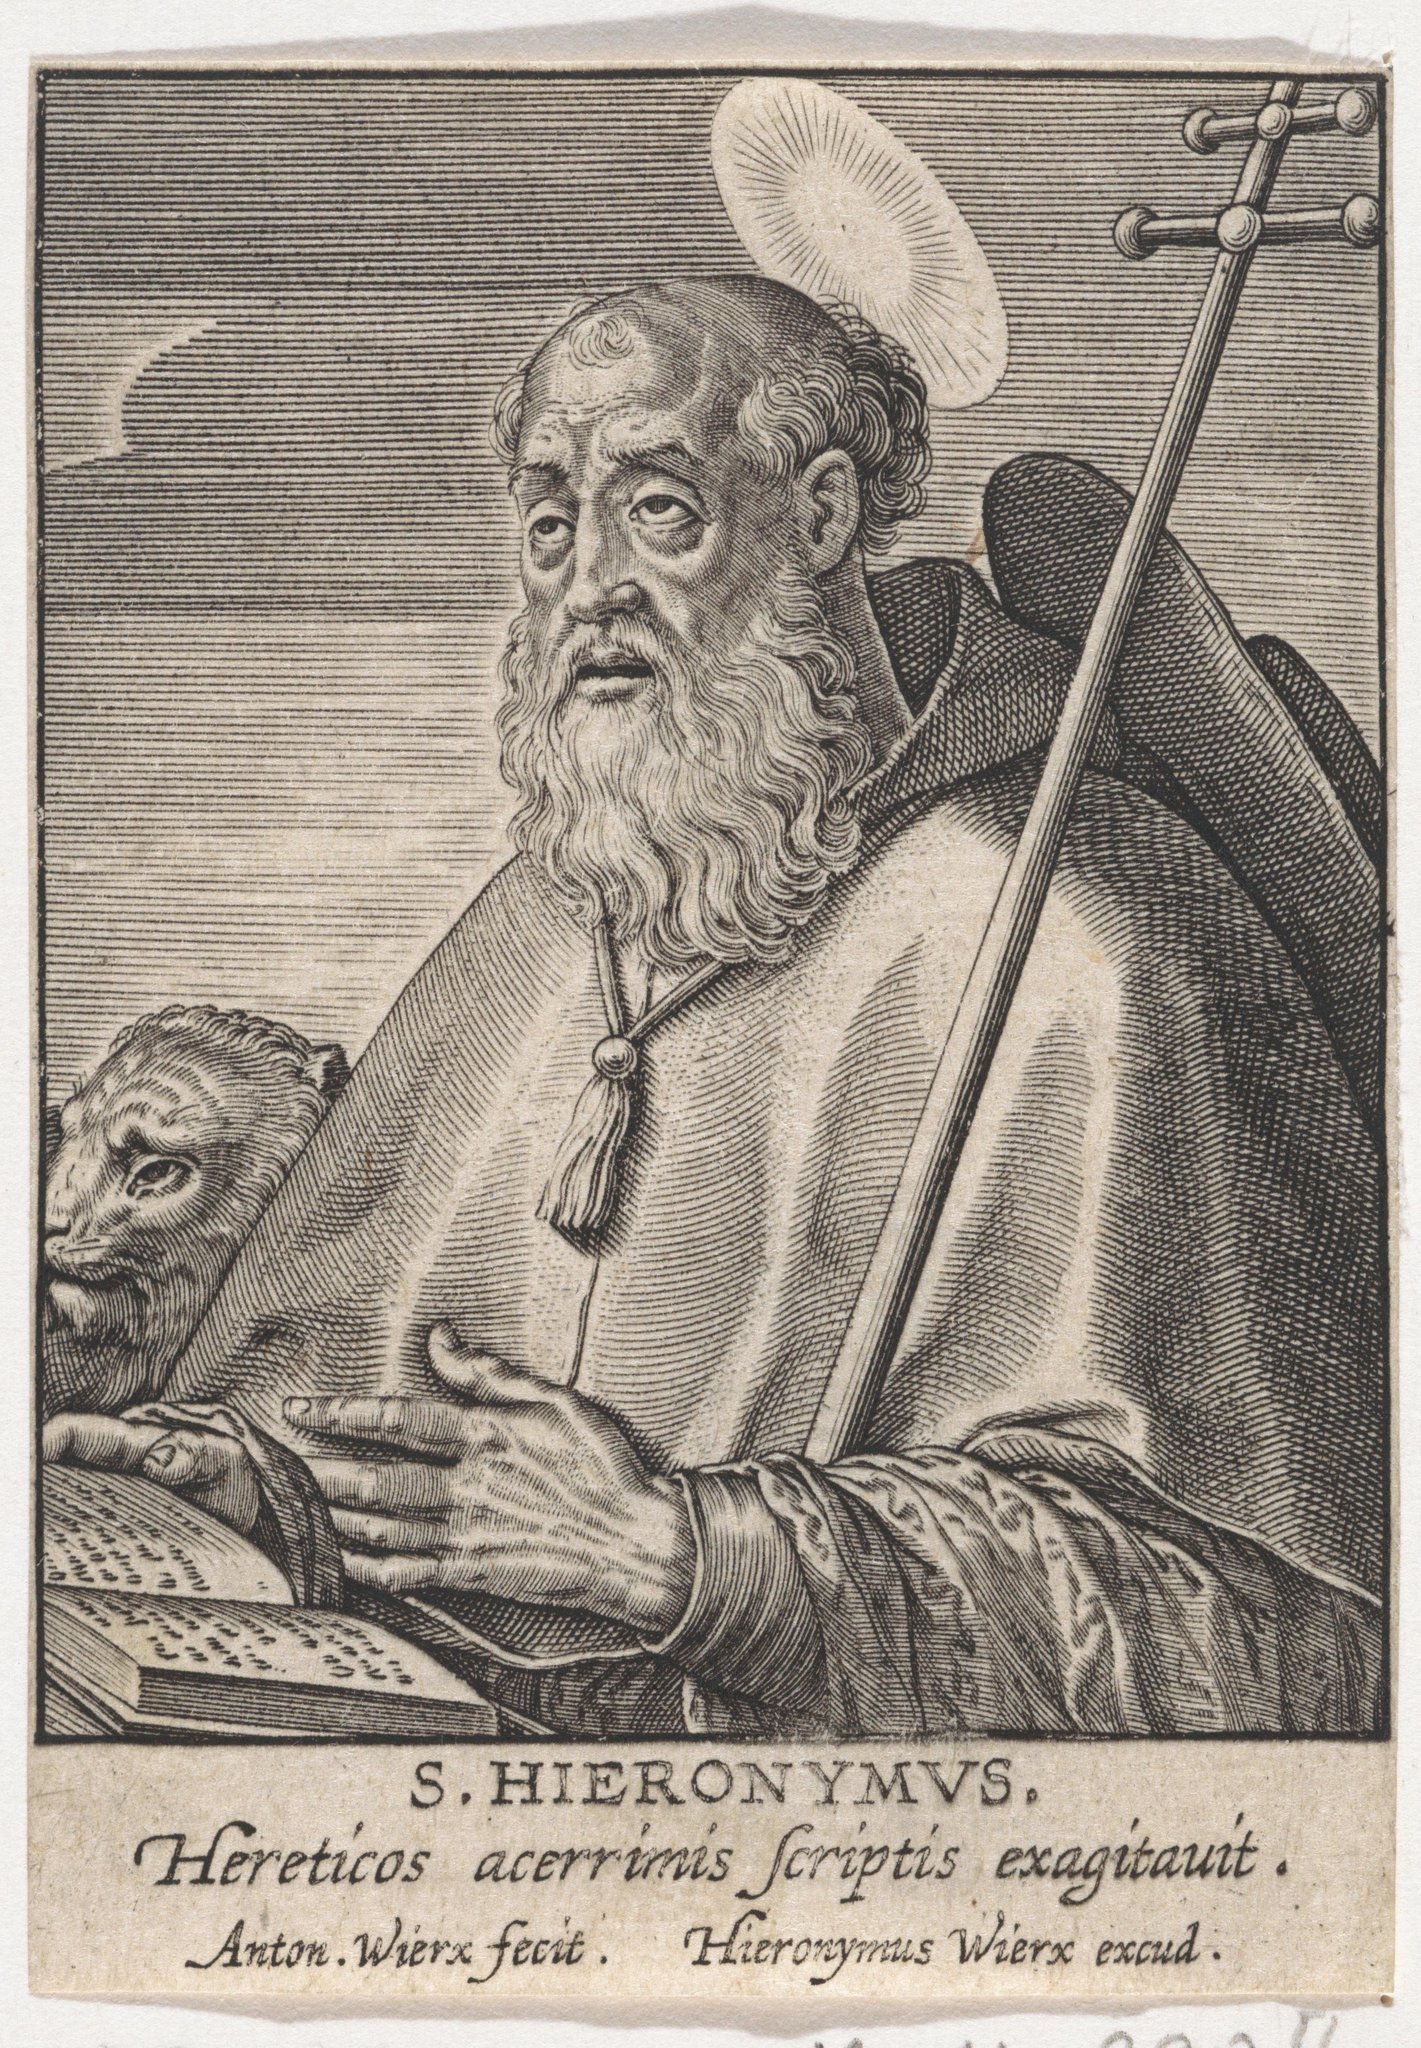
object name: print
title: Kerkvader Hieronymus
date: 1604-1619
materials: paper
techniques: engraving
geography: antwerp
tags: the four latin (western) fathers of the church together: ambrose (usually as bishop), jerome (usually as cardinal), augustine (usually as bishop), gregory the great (usually as pope), the monk and hermit jerome (hieronymus); possible attributes: book, cardinal's hat, crucifix, hour-glass, lion, skull, stone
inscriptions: collector's mark: Lugt 2228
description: De H. Hieronymus is gekleed als pelgrim, onder zijn arm een kruisstaf. In zijn hand houdt hij een opengeslagen boek. Naast hem de leeuw. In de marge een onderschrift in het Latijn.